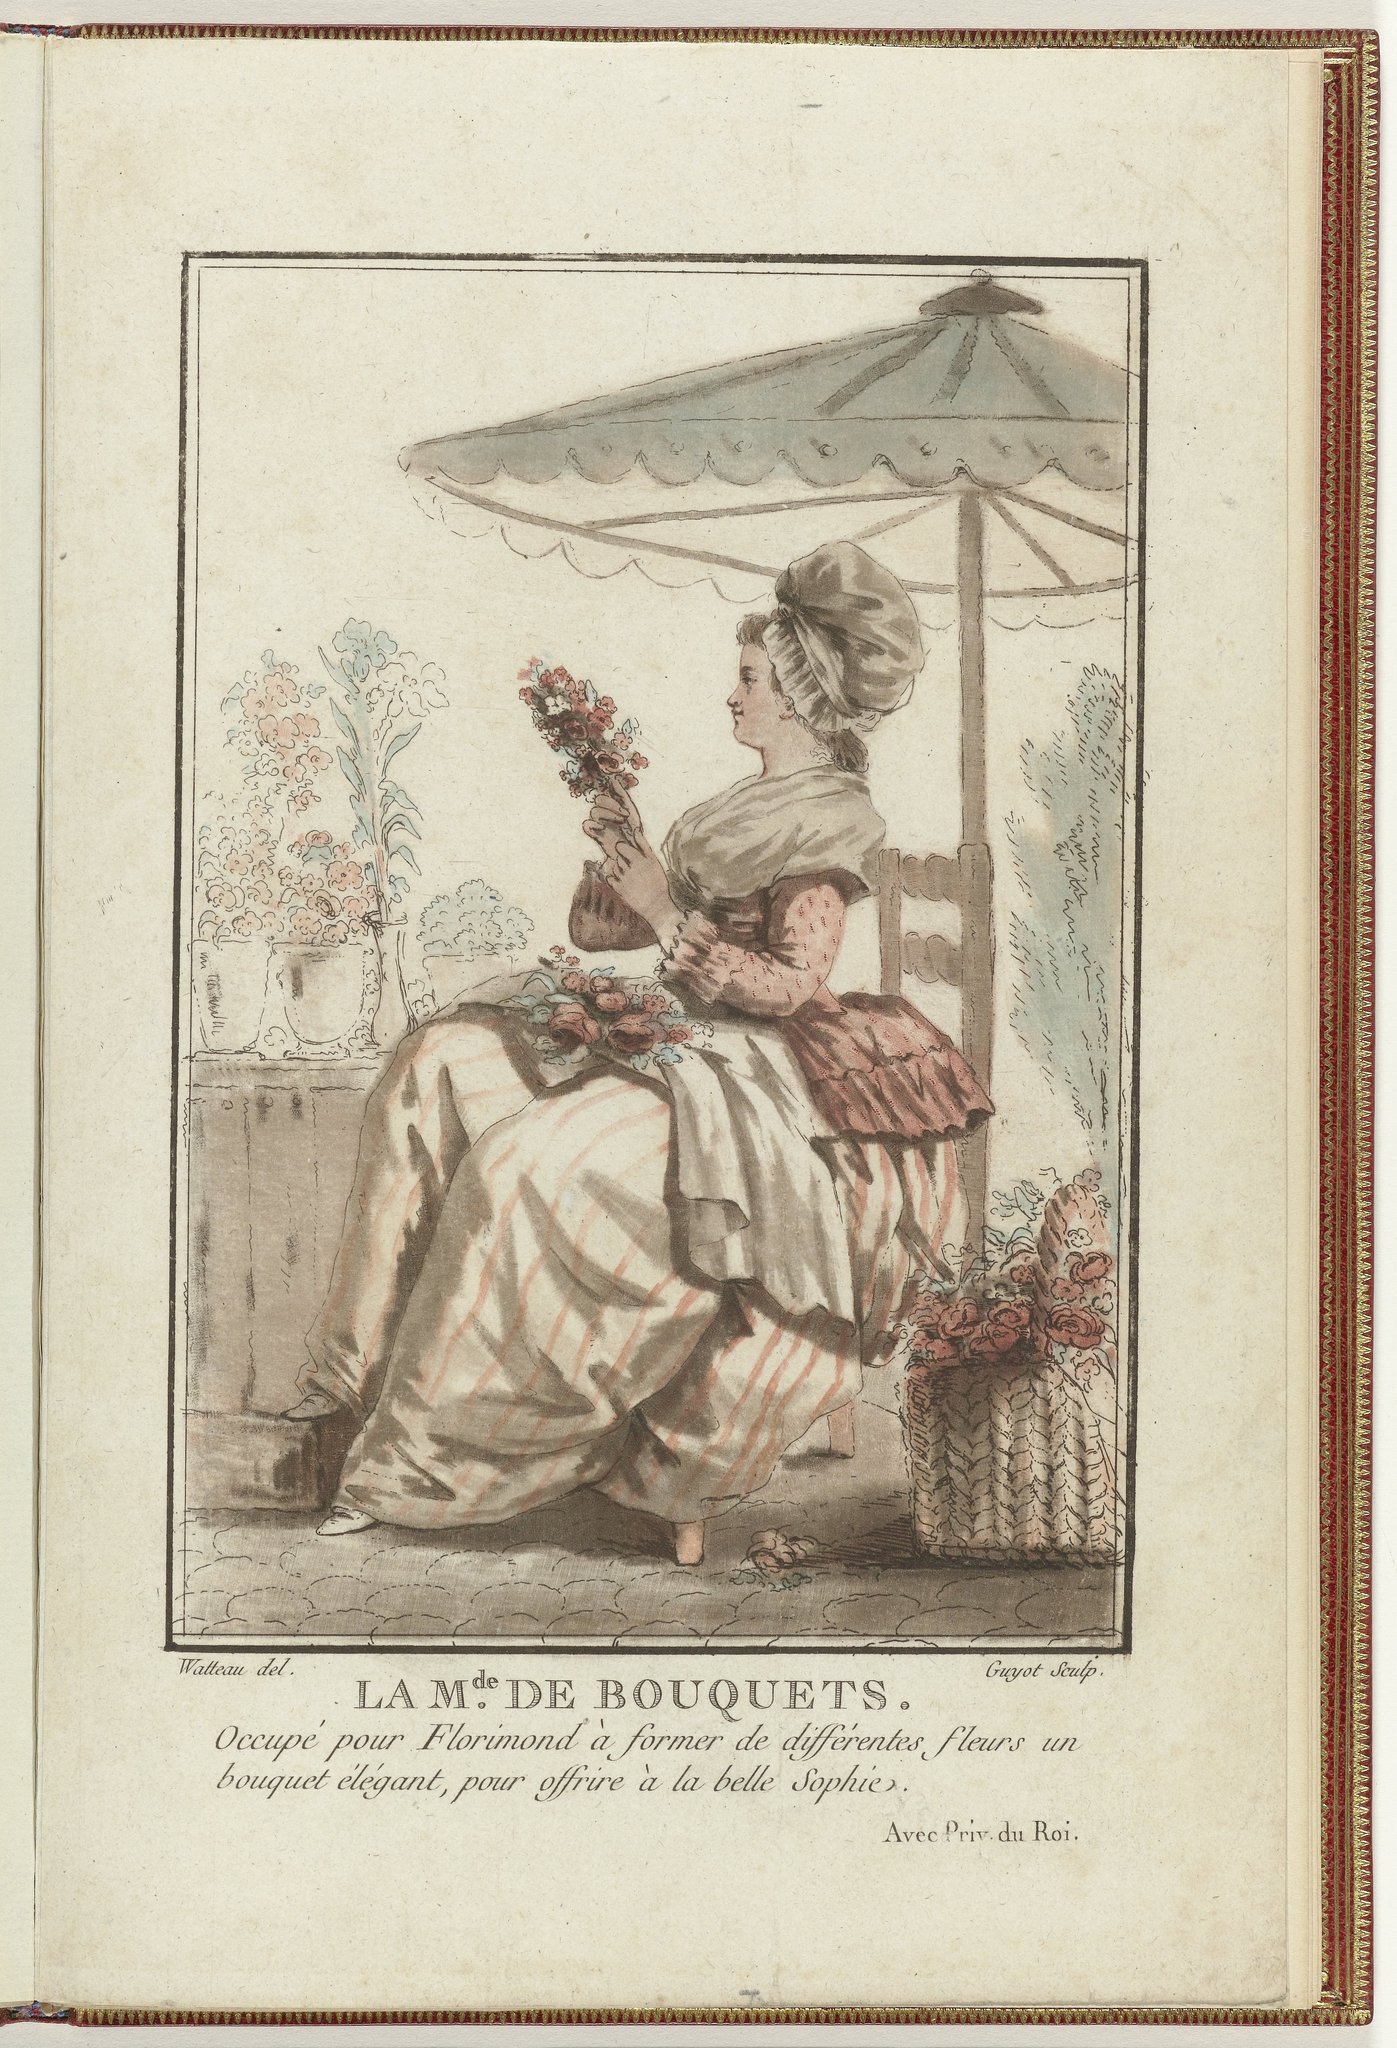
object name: costume print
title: Cris et costumes de Paris...dessiné par Watteau et Gravé en Couleur par Guyot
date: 1786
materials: paper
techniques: aquatint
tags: clothes, costume (+ women's clothes), 'cris de paris', cries of london, etc.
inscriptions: title: ‘LA M.de DE BOUQUETS.’, signature: ‘Guyot sculp.’, privilege: ‘Avec Privi. du Roi.’, signature: ‘Watteau del.’, caption: ‘Occupé pour Florimond a former de différentes fleurs un bouquet élégant, pour offrire a la belle Sophie.’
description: Onder een parasol zit een bloemenverkoopster, van opzij gezien, naar links, een boeketje bloemen te schikken. Ze draagt een witte muts op het hoofd en is gekleed volgens de mode van 1786.. Naast haar een mand met bloemen. Op de achtergrond enkele bloempotten op een balustrade.